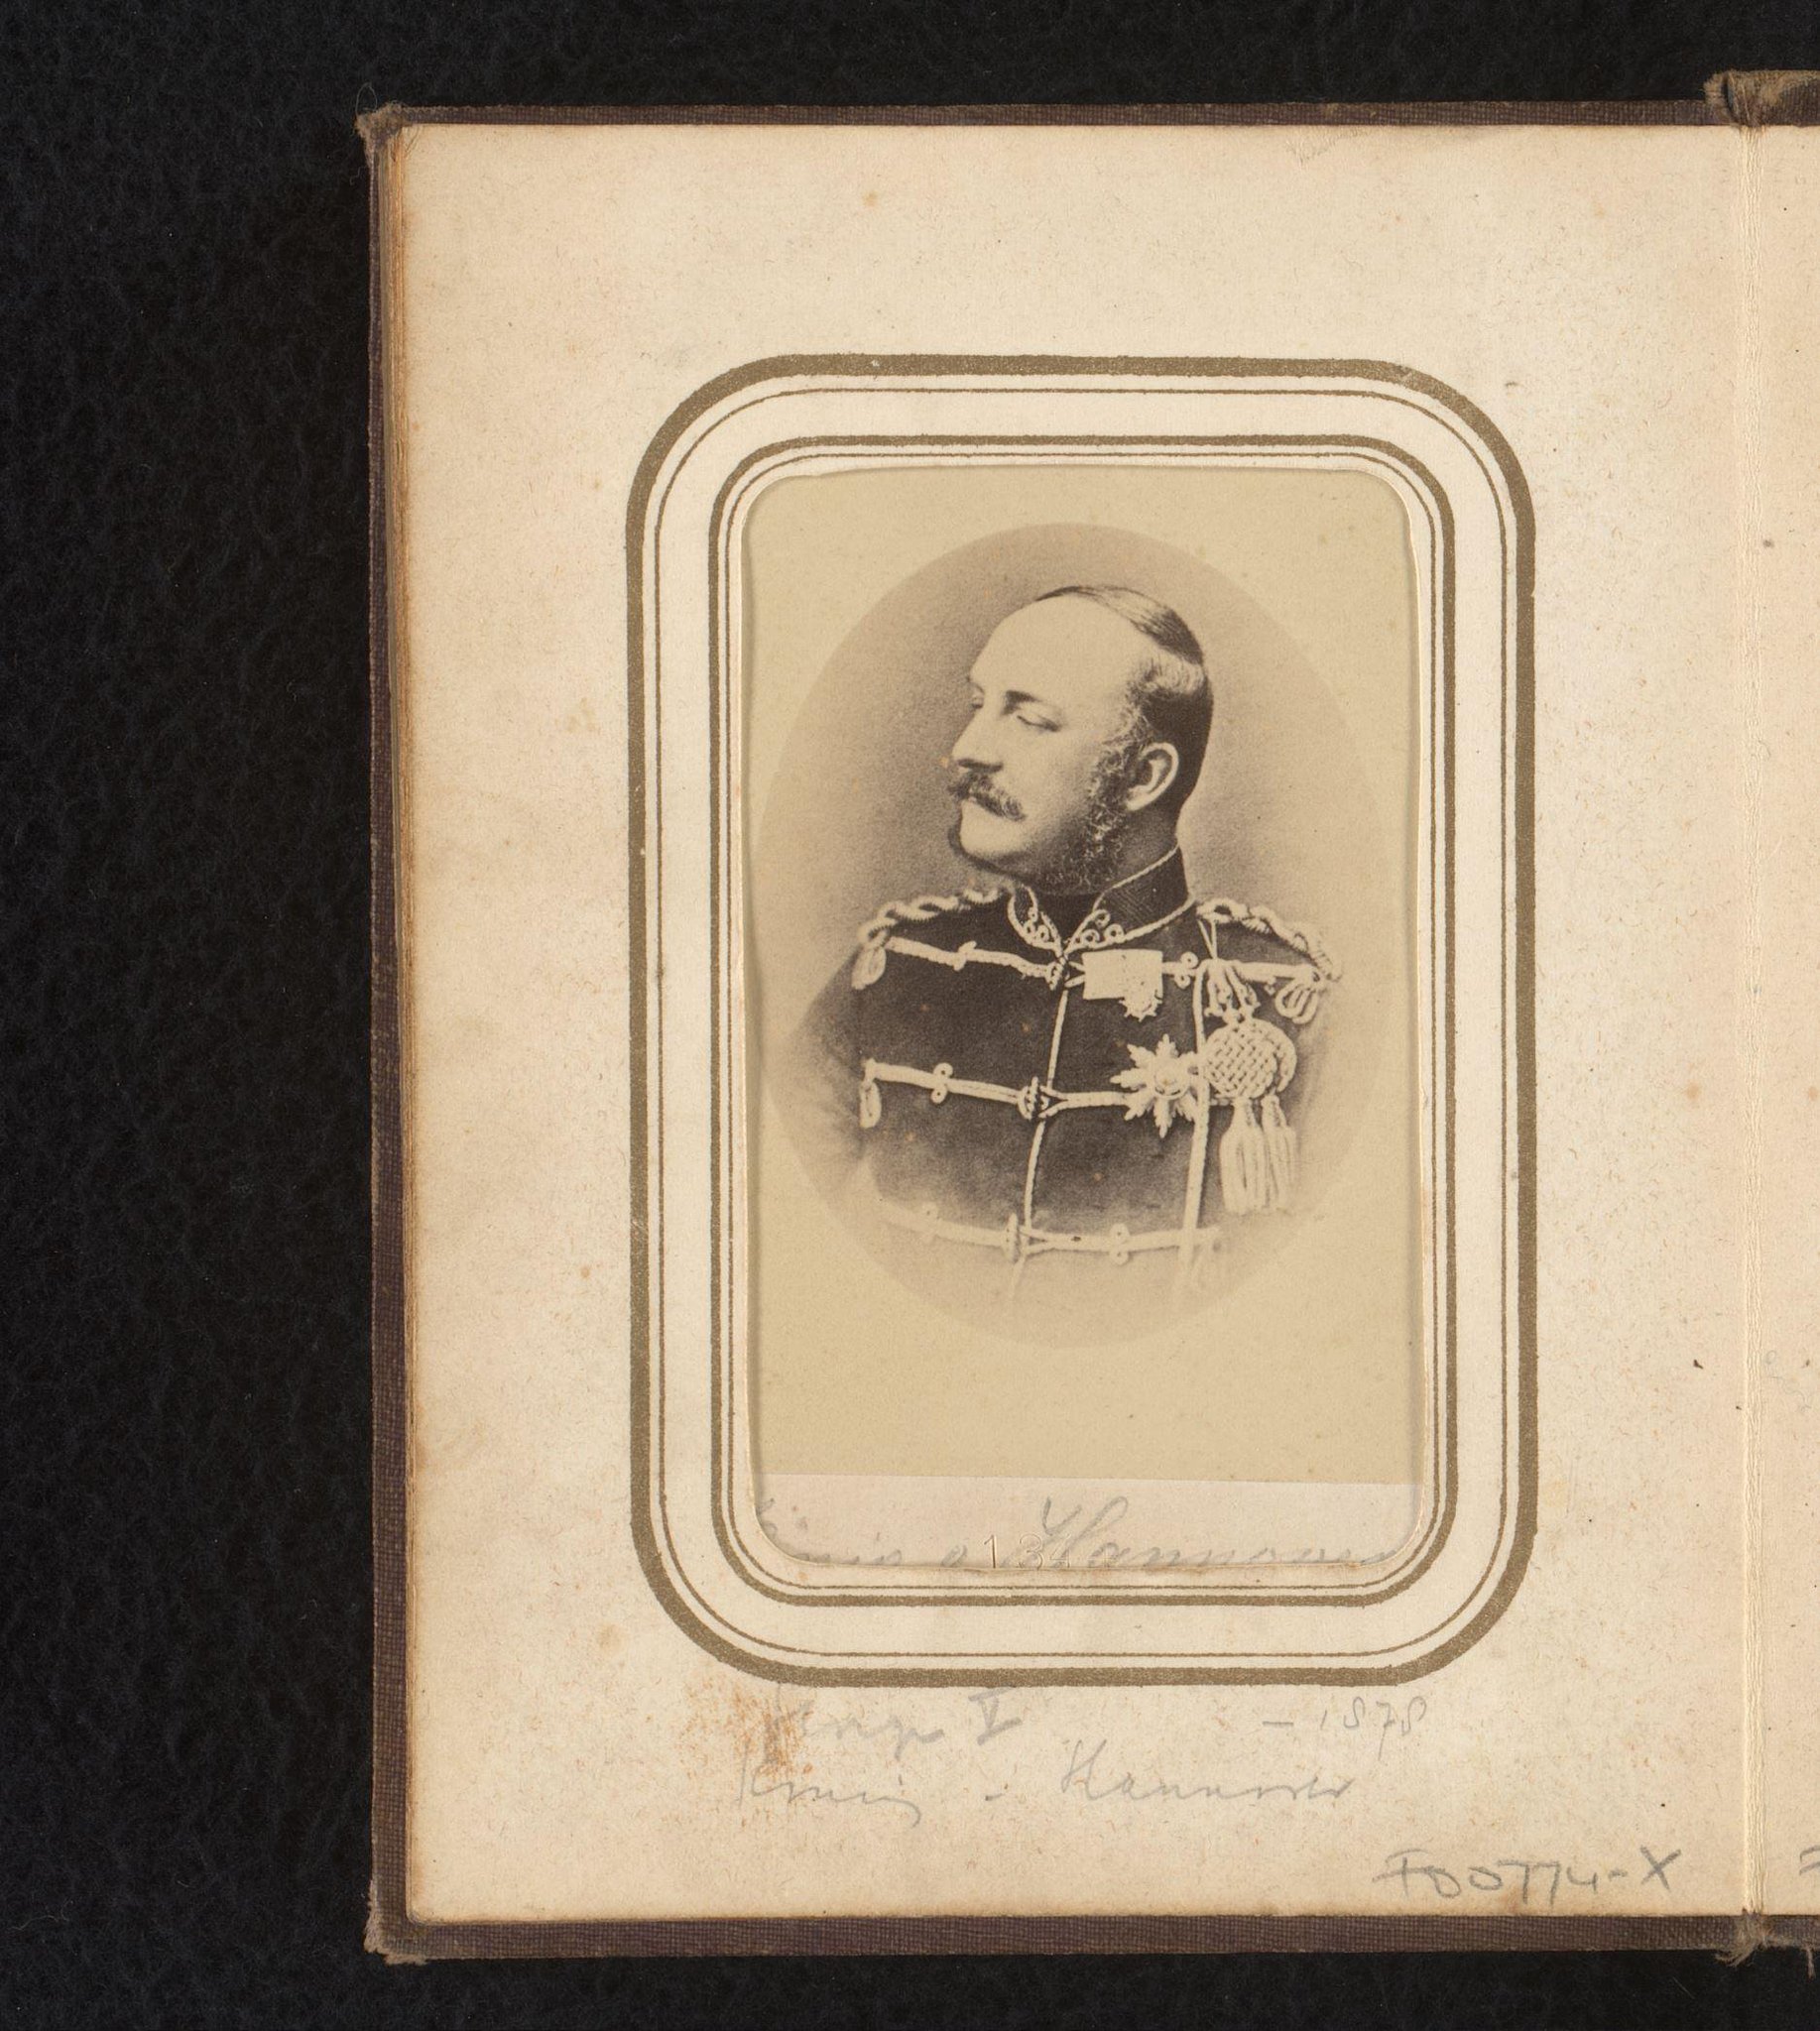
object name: album leaf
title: Portret van koning George V van Hannover in uniform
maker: Anonymous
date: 1860-1878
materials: cardboard, photographic support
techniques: albumen print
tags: historical persons, (military) uniforms, king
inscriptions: number: ‘1344’, annotation: ‘George V -1878/ koning v Hannover’, annotation: ‘König v Hannover’